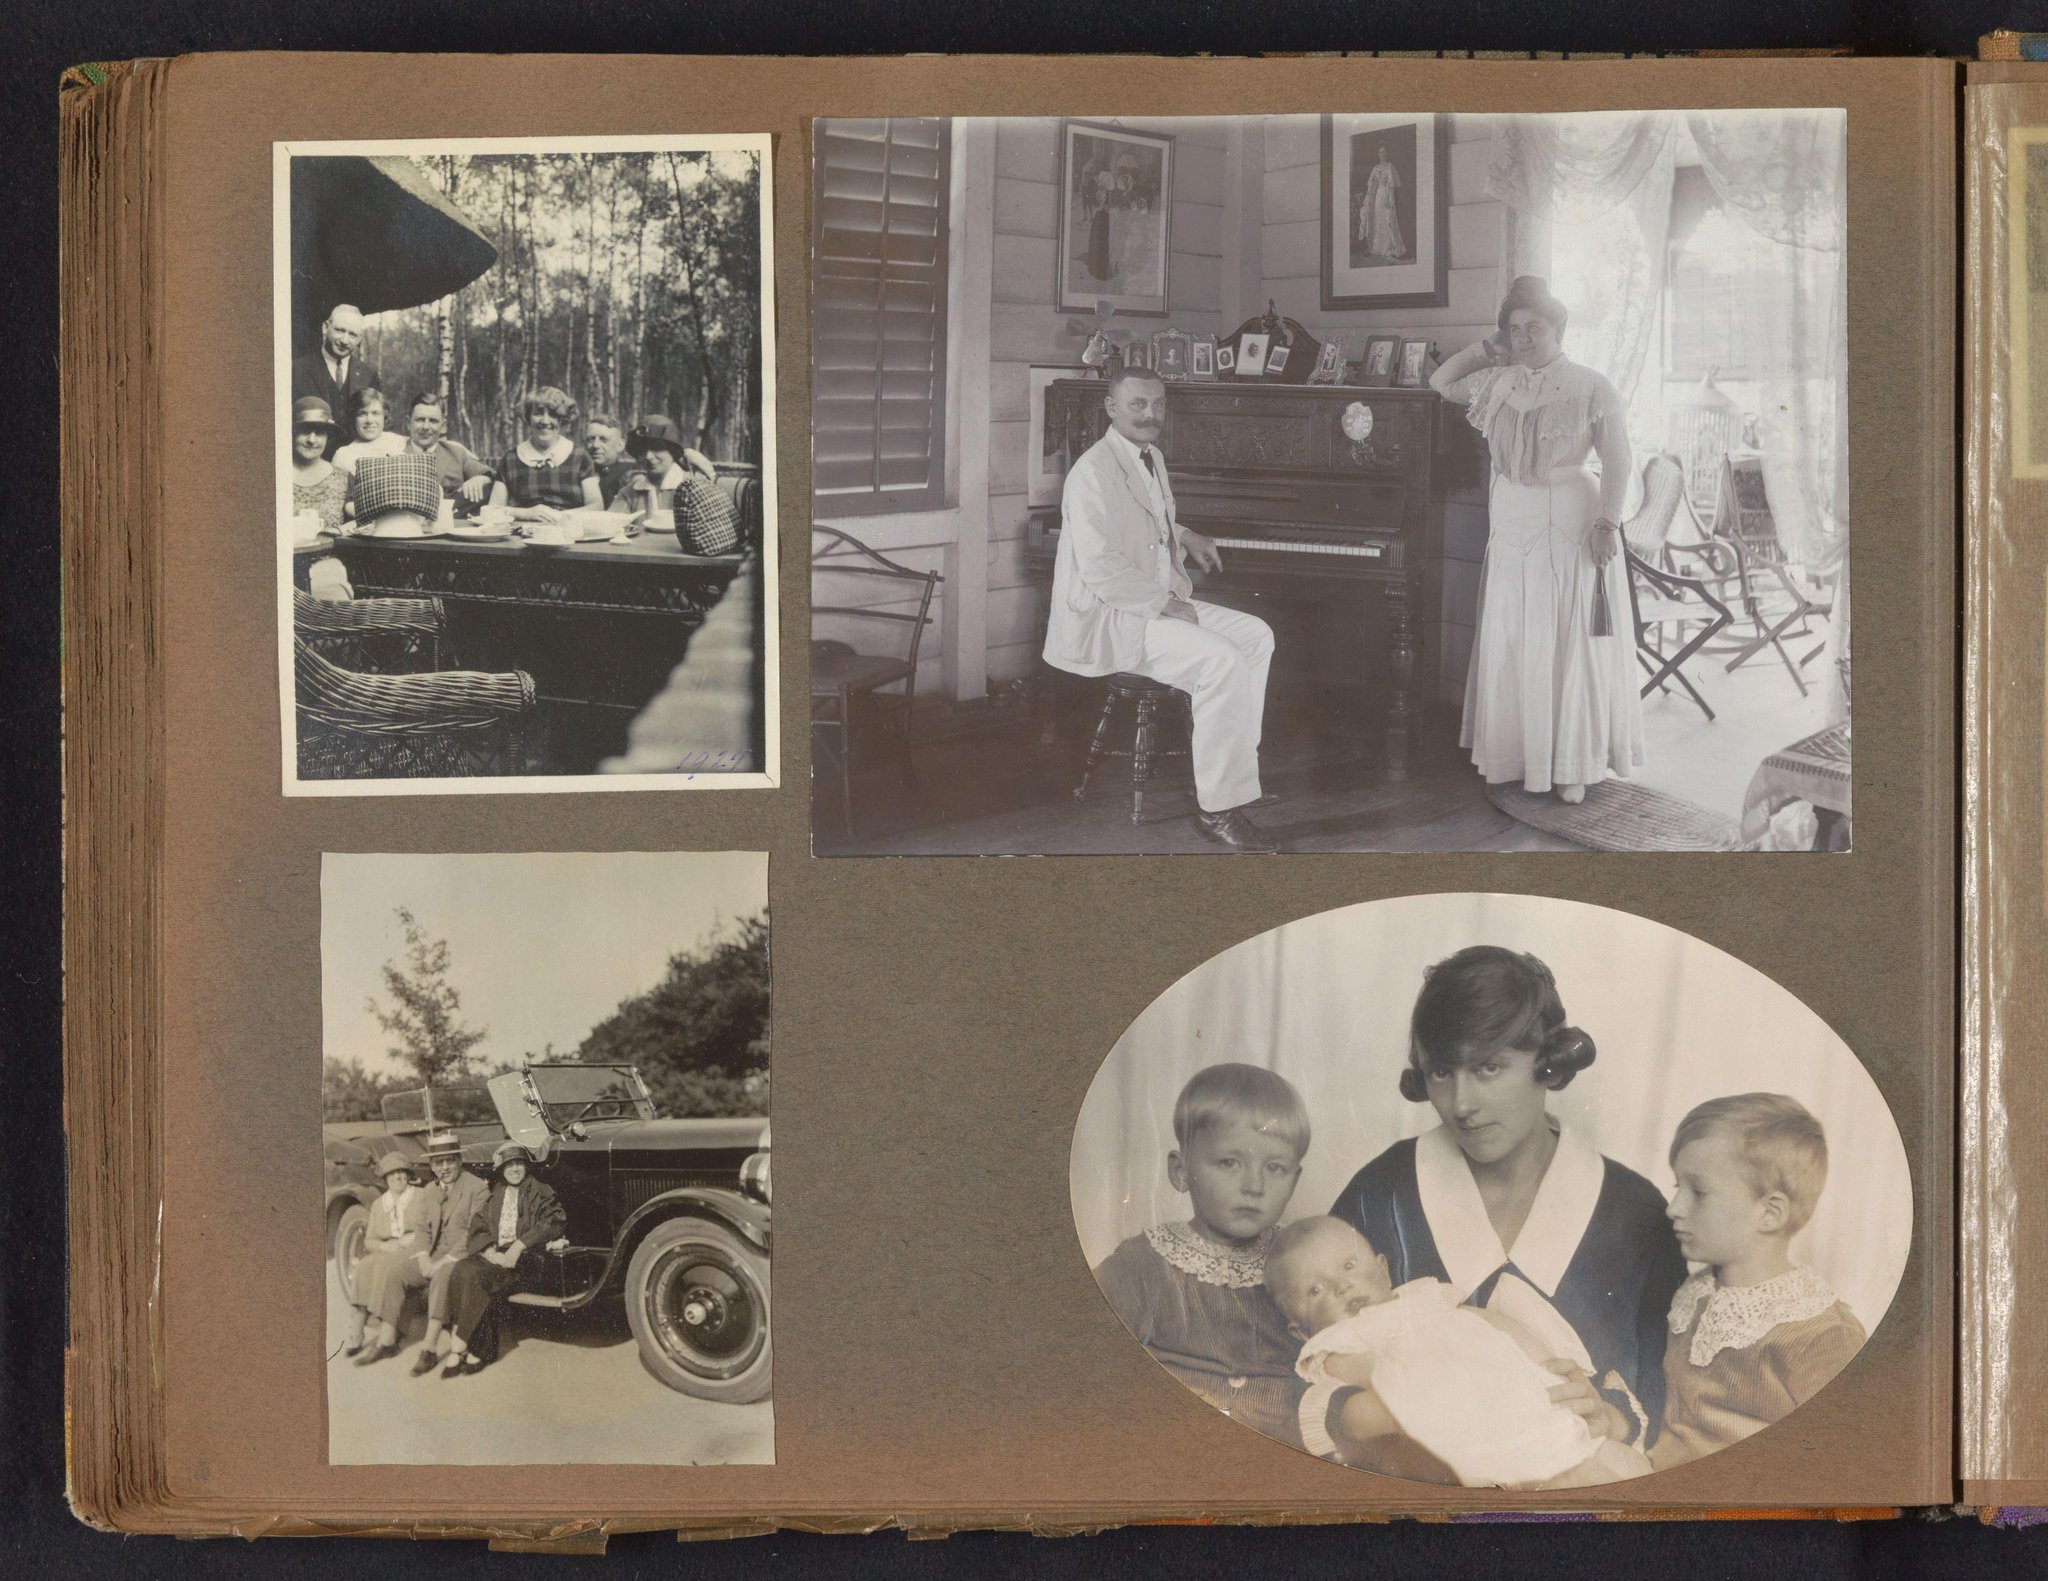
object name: album leaf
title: Gezelschappen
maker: Anonymous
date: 1900-1925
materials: cardboard, photographic support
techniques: gelatin silver print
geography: netherlands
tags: adult woman, adult man, child, pavement, terrace in front of inn or restaurant, mother and baby or young child, automobile, netherlands, suriname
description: Albumblad met foto's van gezelschappen, zittend op het terras van een uitspanning in het bos en zittend op de treeplank van een auto. Ook een groepsportret van een moeder met drie kleine kinderen. Voorts een opname van een man en een vrouw bij een piano, vermoedelijk in Suriname. Onderdeel van Fotoalbum van een onbekende Nederlandse familie met connecties in Suriname en Nederlands-Indië (2).